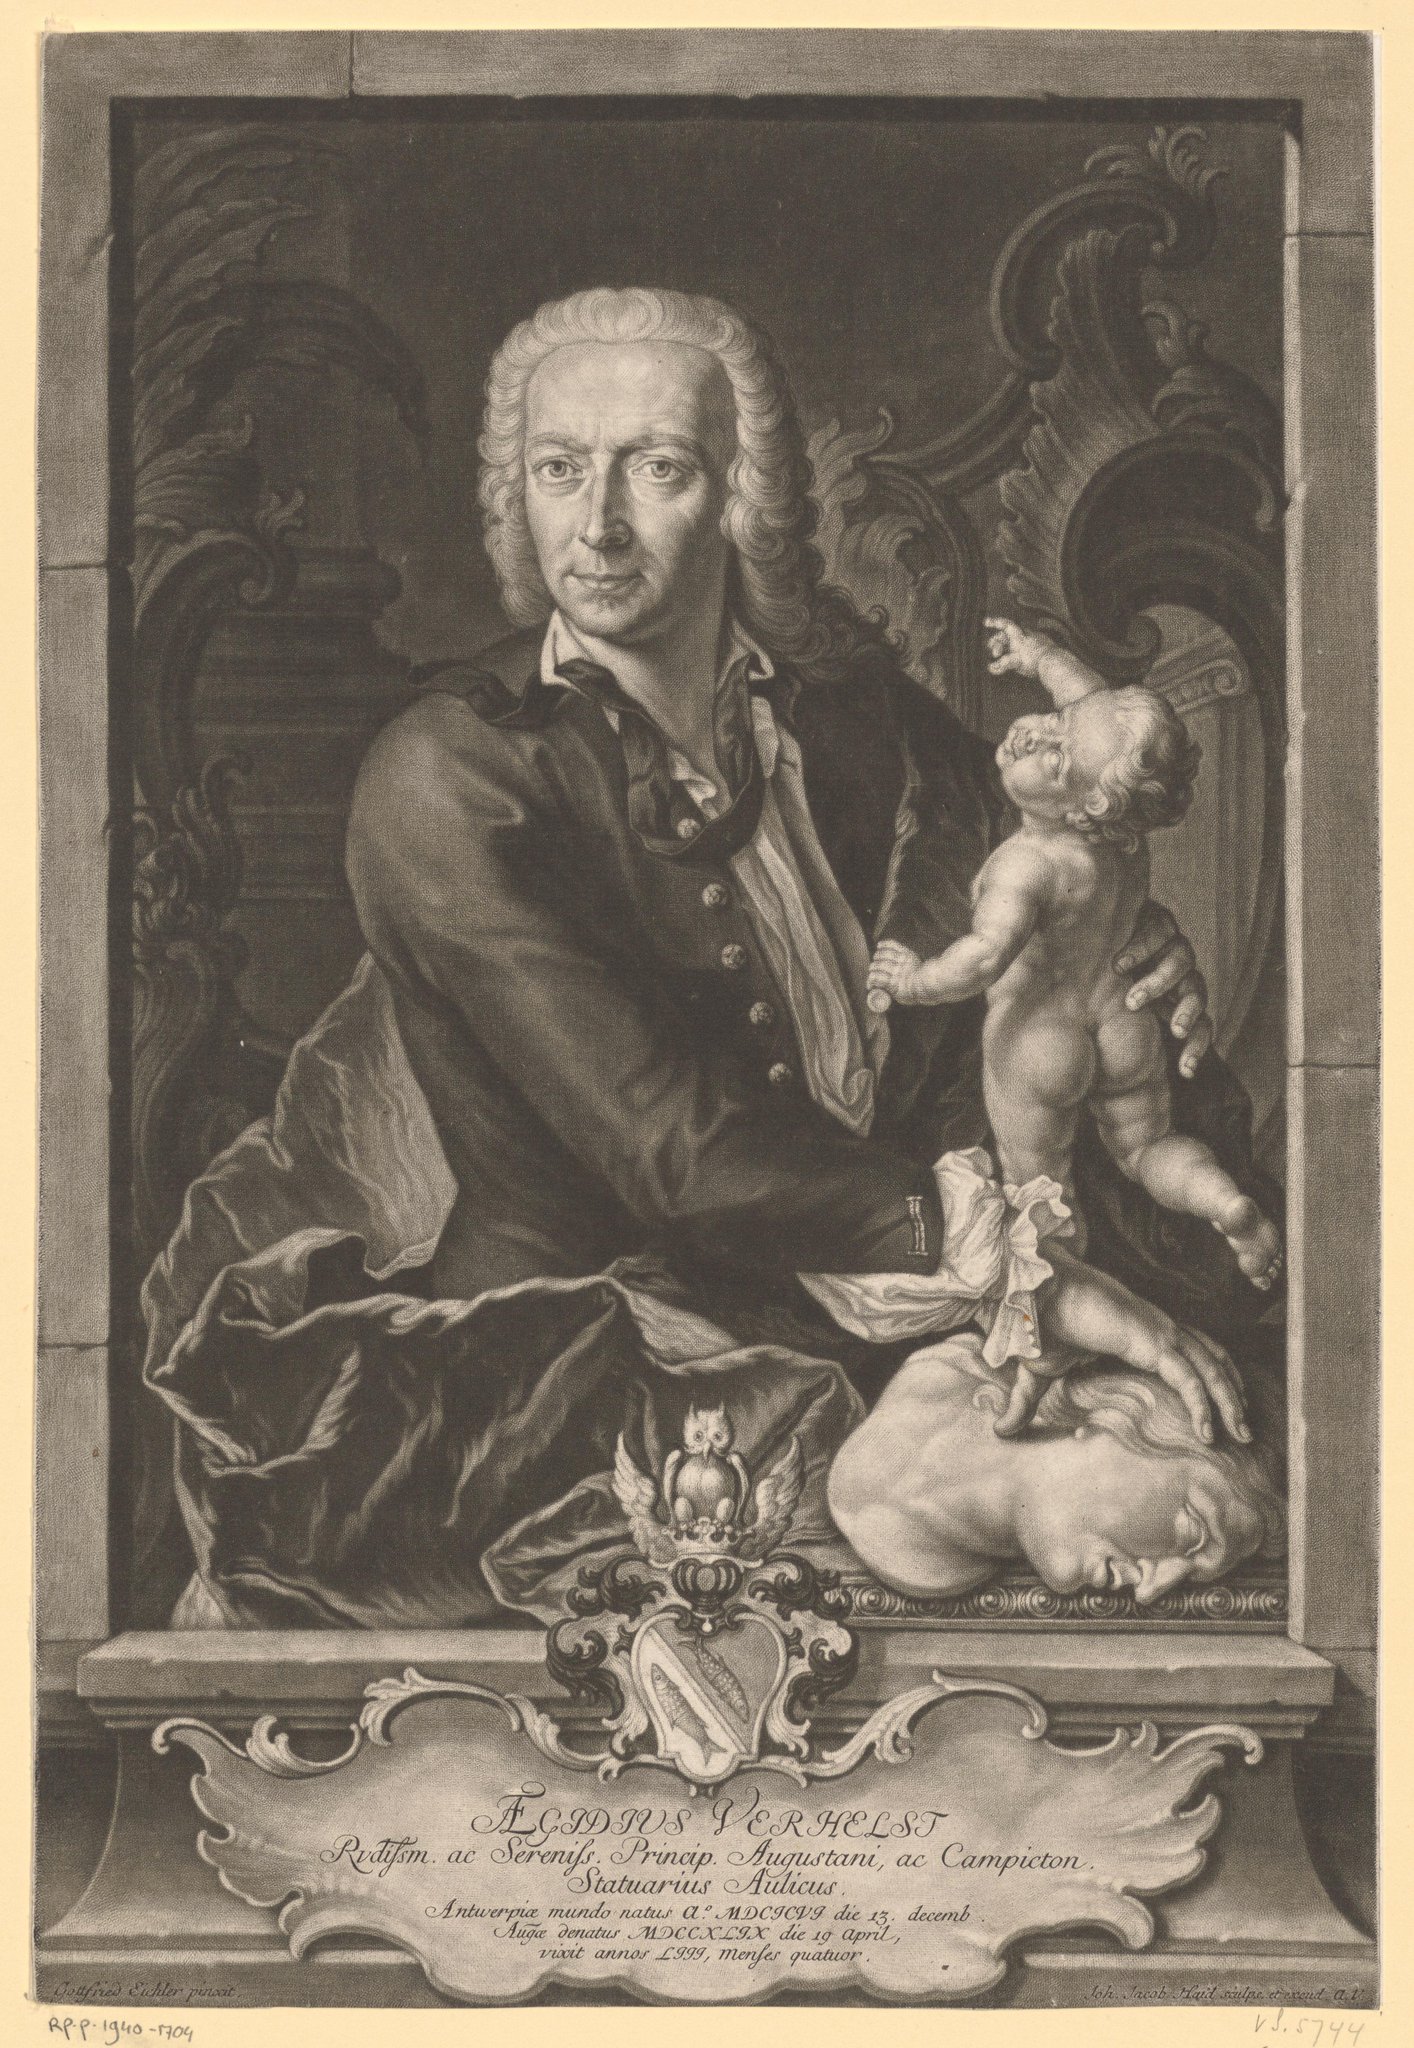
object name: print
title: Portret van Aegidius Verhelst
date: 1749-1767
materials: paper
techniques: engraving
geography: augsburg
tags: antwerp, augsburg, sculptor, aegid verhelst (i), rocaille ornament, portrait, self-portrait of sculptor, historical persons, sculpture, armorial bearing, heraldry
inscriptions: collector's mark: Lugt 2166, collector's mark: Lugt 2760